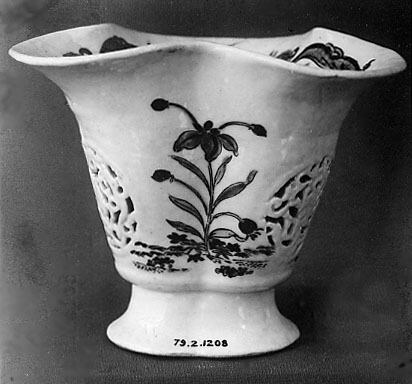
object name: cup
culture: japanese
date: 1701-1800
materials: enamel, porcelain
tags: plants